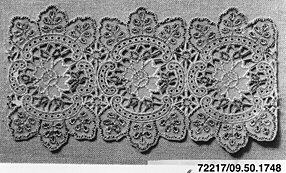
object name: passementerie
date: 1801-1900